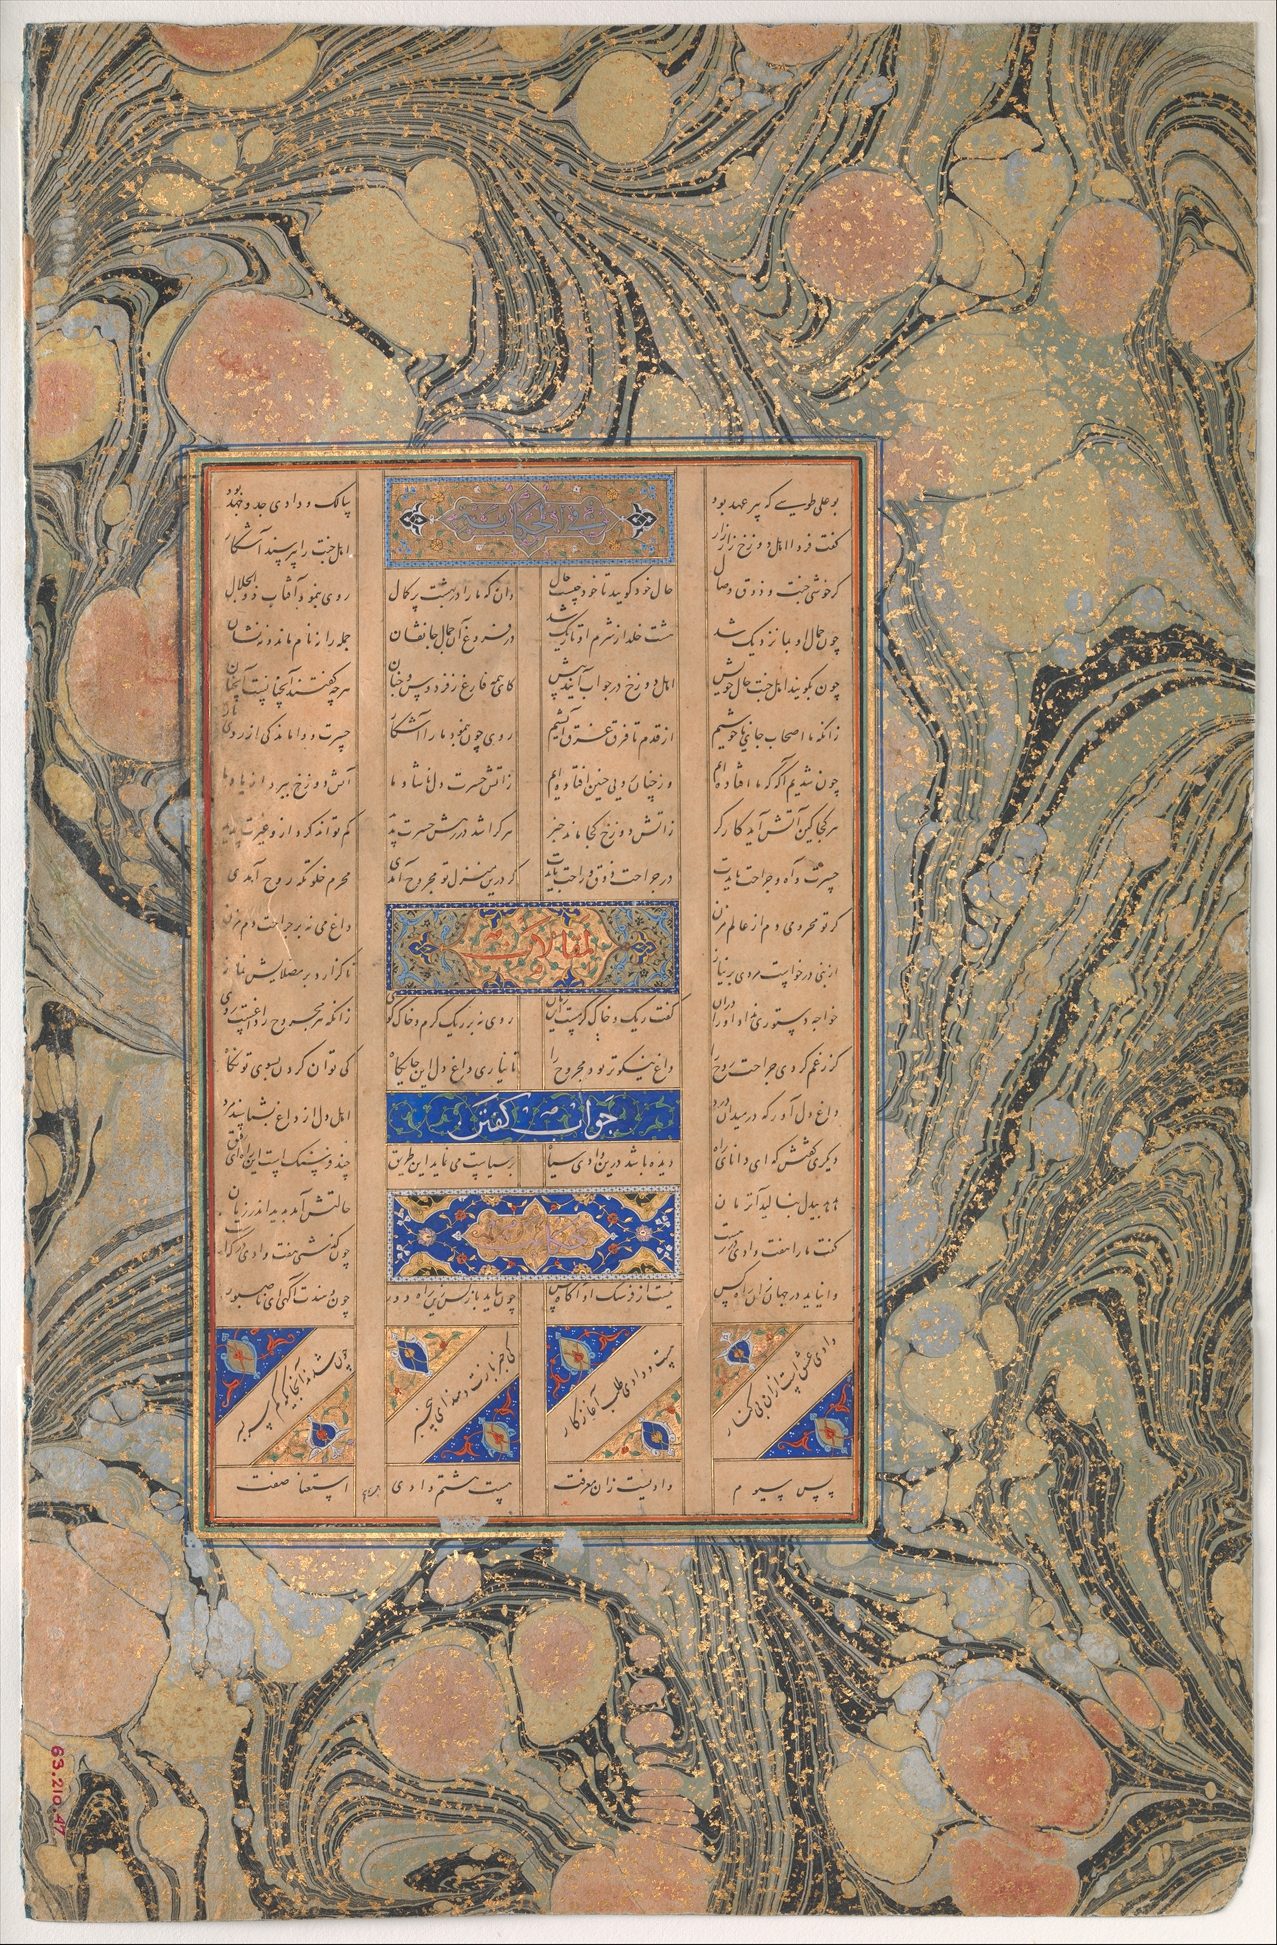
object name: folio from an illustrated manuscript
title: "Allusion to Sura 27:16", Folio from a Mantiq al-Tayr (Language of the Birds)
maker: farid al-din `attar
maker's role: author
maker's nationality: iranian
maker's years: 1142-1220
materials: gold, ink, paper, watercolor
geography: afghanistan